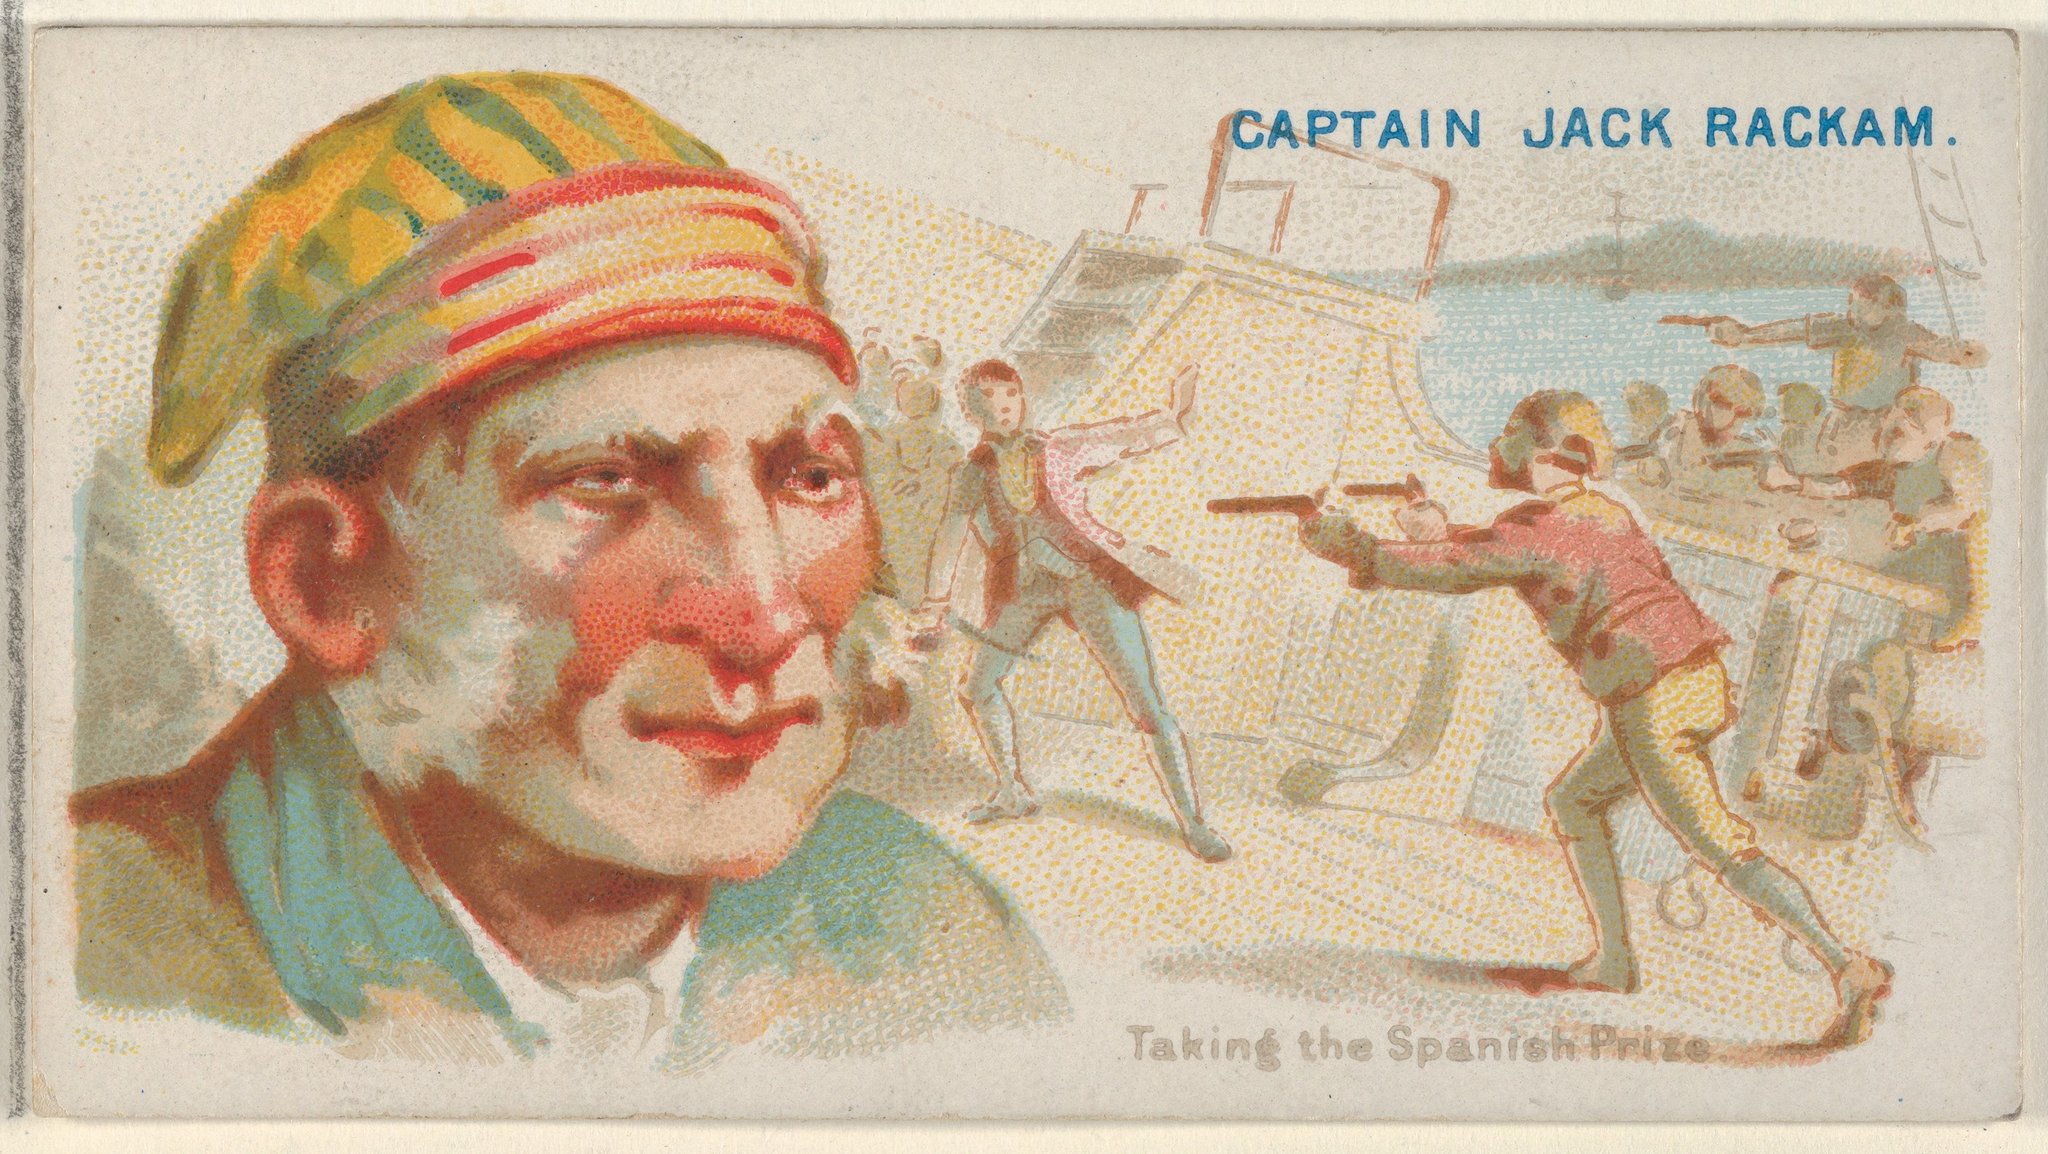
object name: print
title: Captain Jack Rackham, Taking the Spanish Prize, from the Pirates of the Spanish Main series (N19) for Allen & Ginter Cigarettes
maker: allen & ginter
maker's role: publisher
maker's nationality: american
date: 1888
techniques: color lithograph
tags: weapons,men